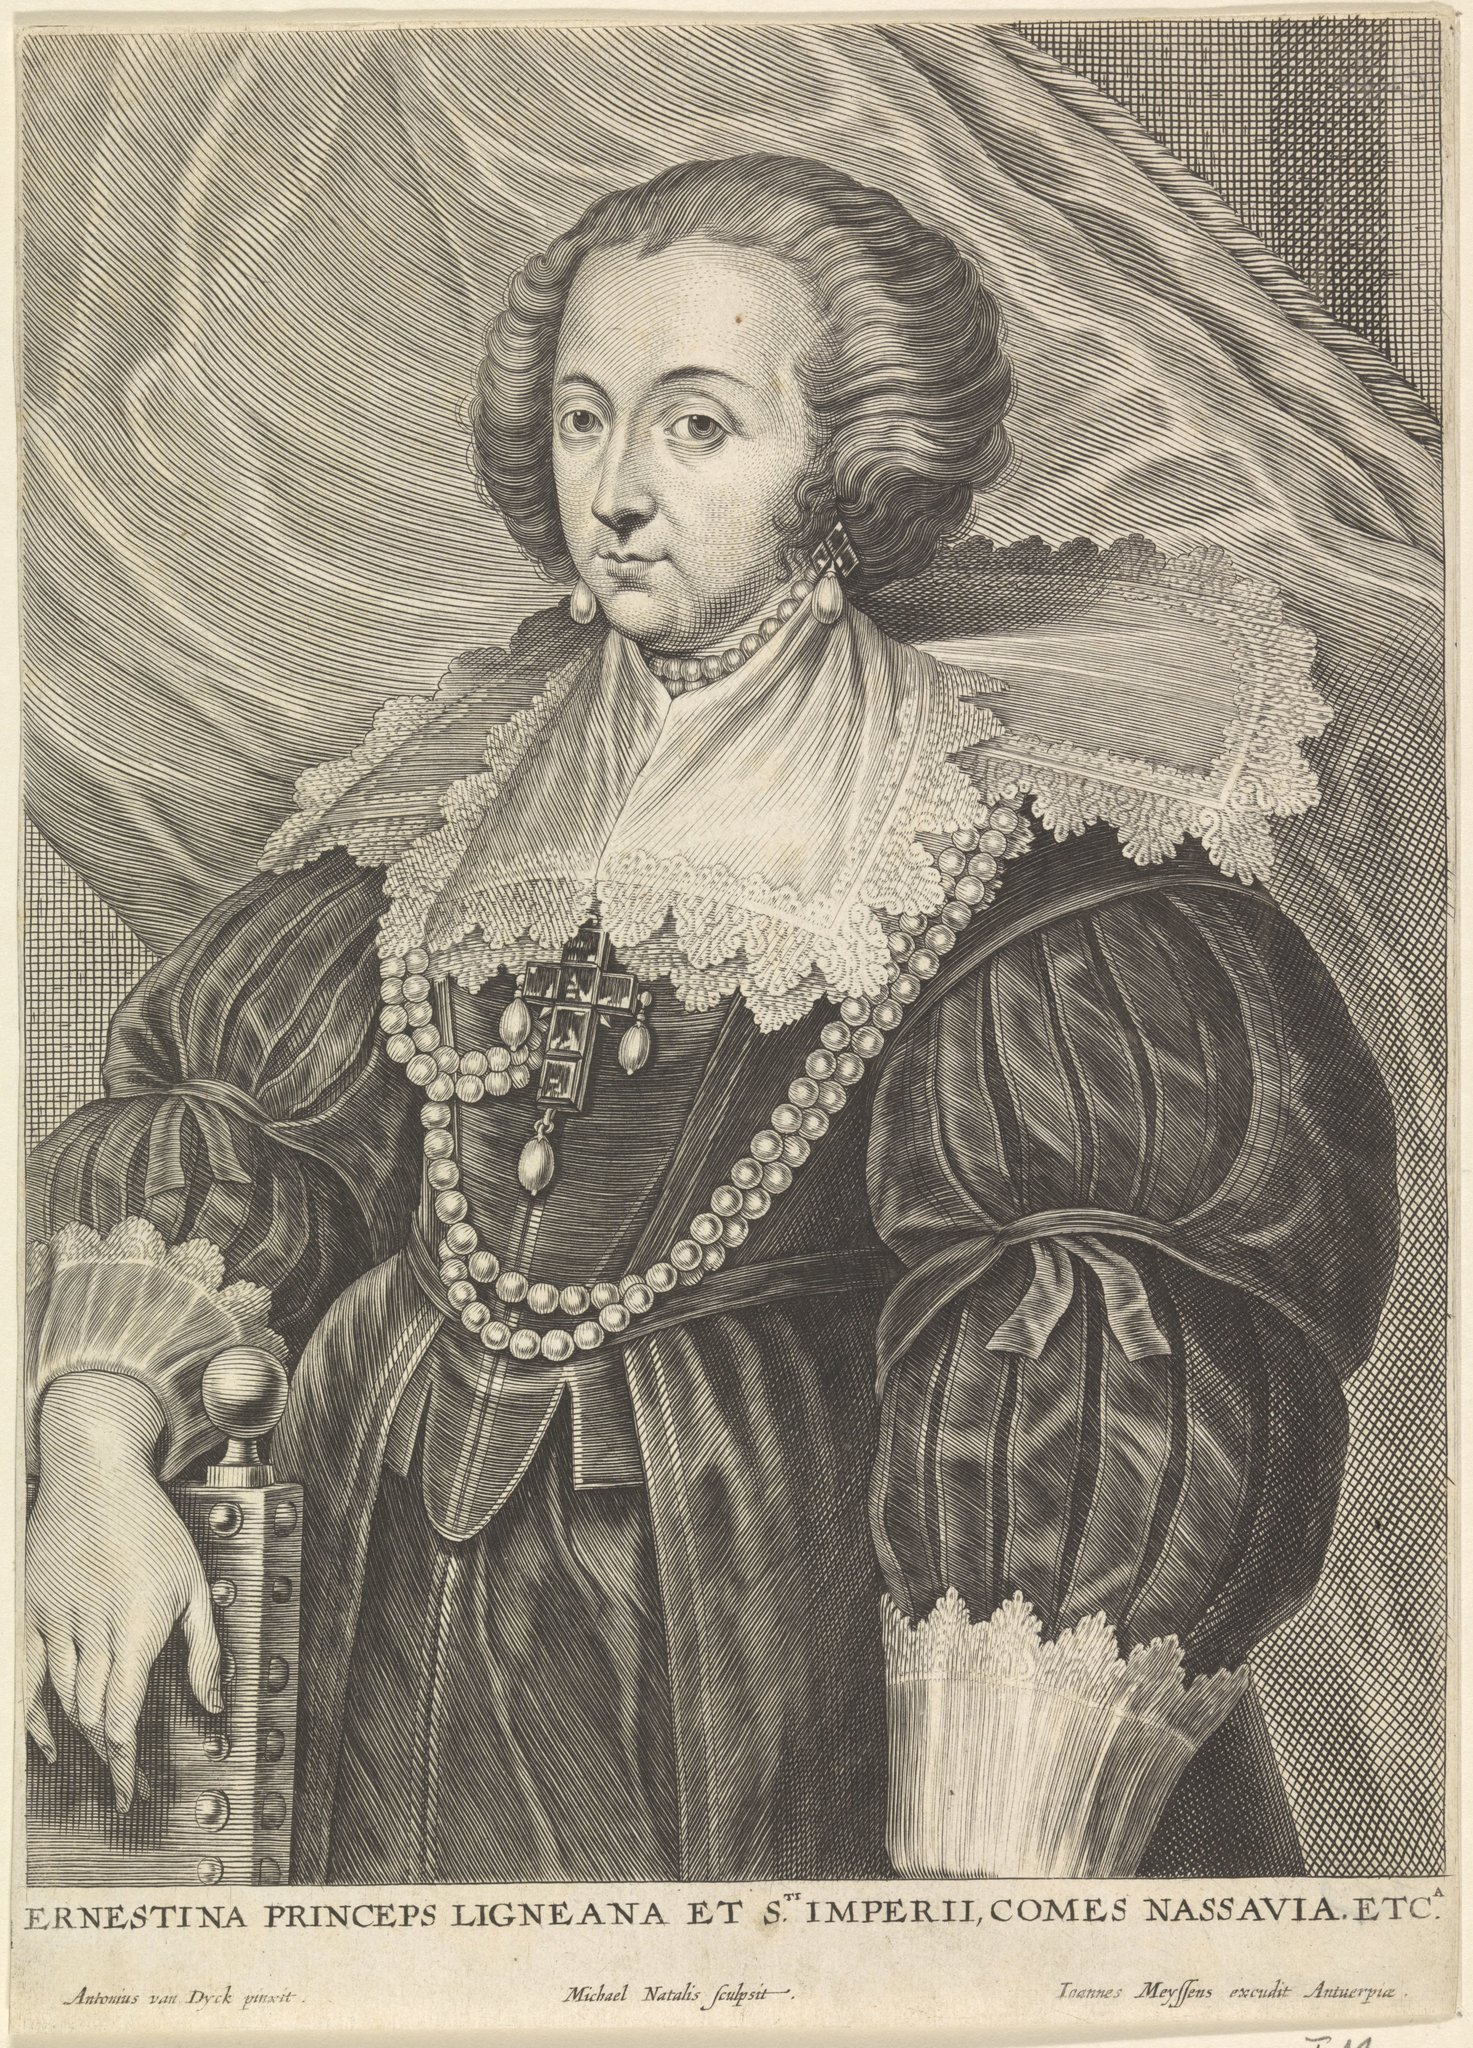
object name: print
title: Portret van Ernestine Yolande de Ligne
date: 1640-1670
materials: paper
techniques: engraving, etching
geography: antwerp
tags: ernestine yolande de ligne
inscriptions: collector's mark: Lugt 963